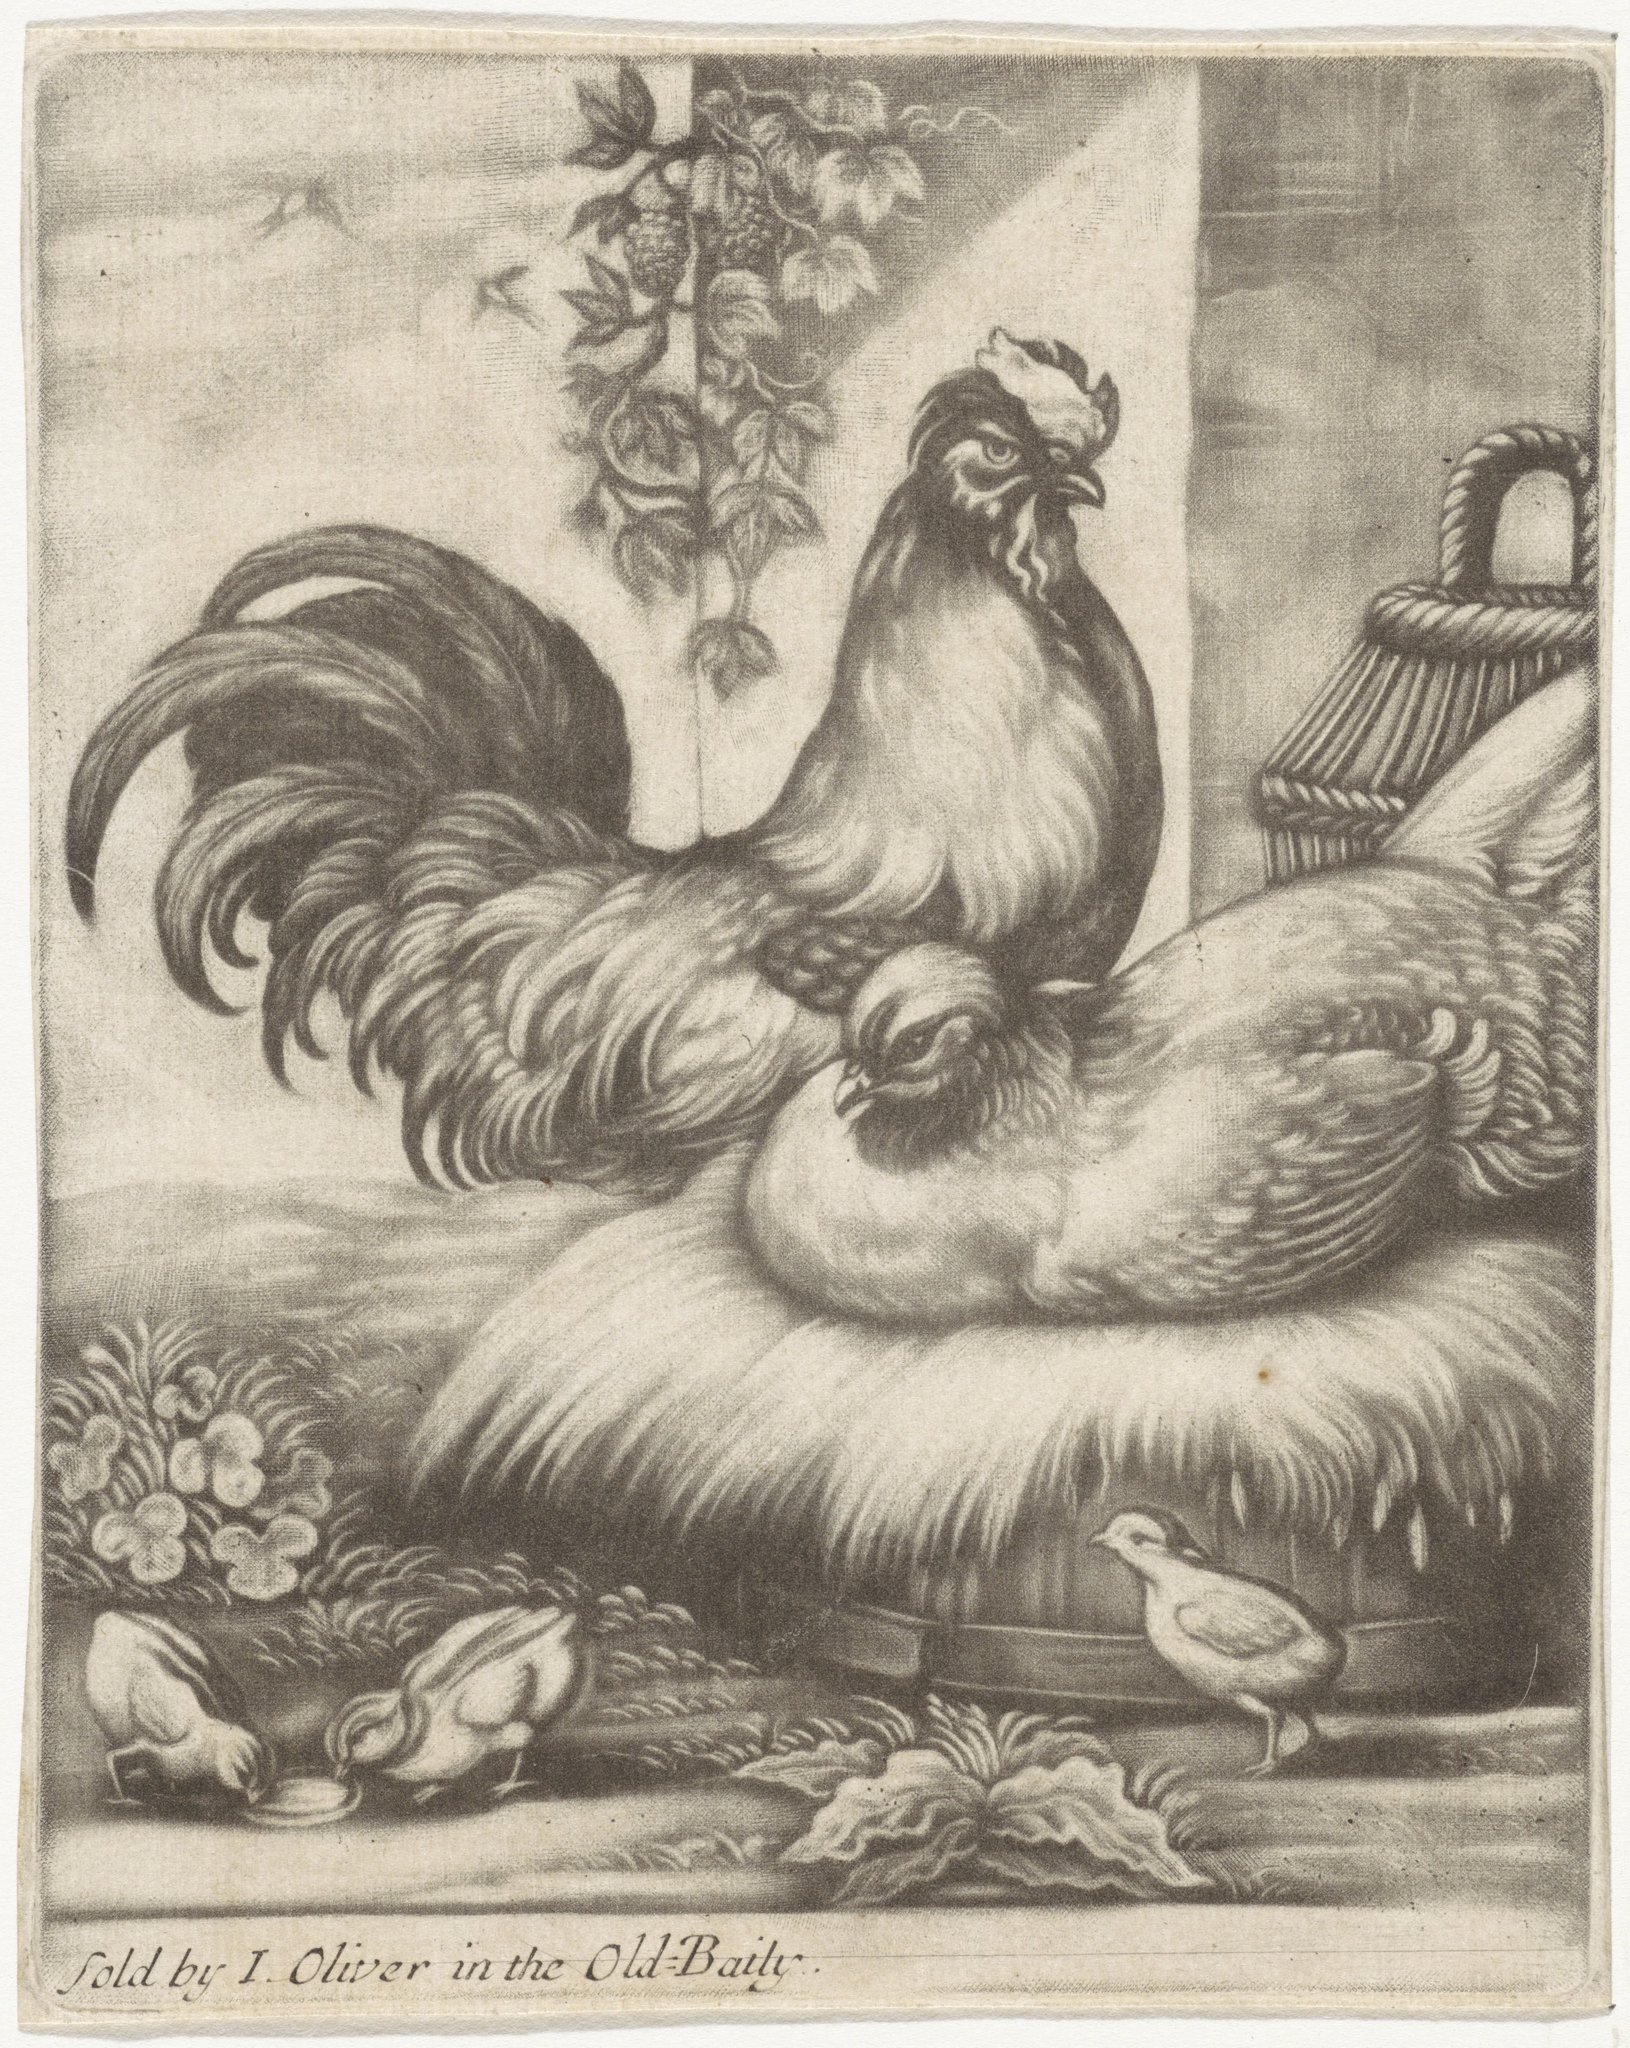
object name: print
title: Haan en hen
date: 1667-1718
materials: paper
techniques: engraving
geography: england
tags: fowl (cock, hen, chicken, etc.)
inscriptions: collector's mark: Lugt 2228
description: Een haan en een hen zitten op een nest met enkele kuikens.